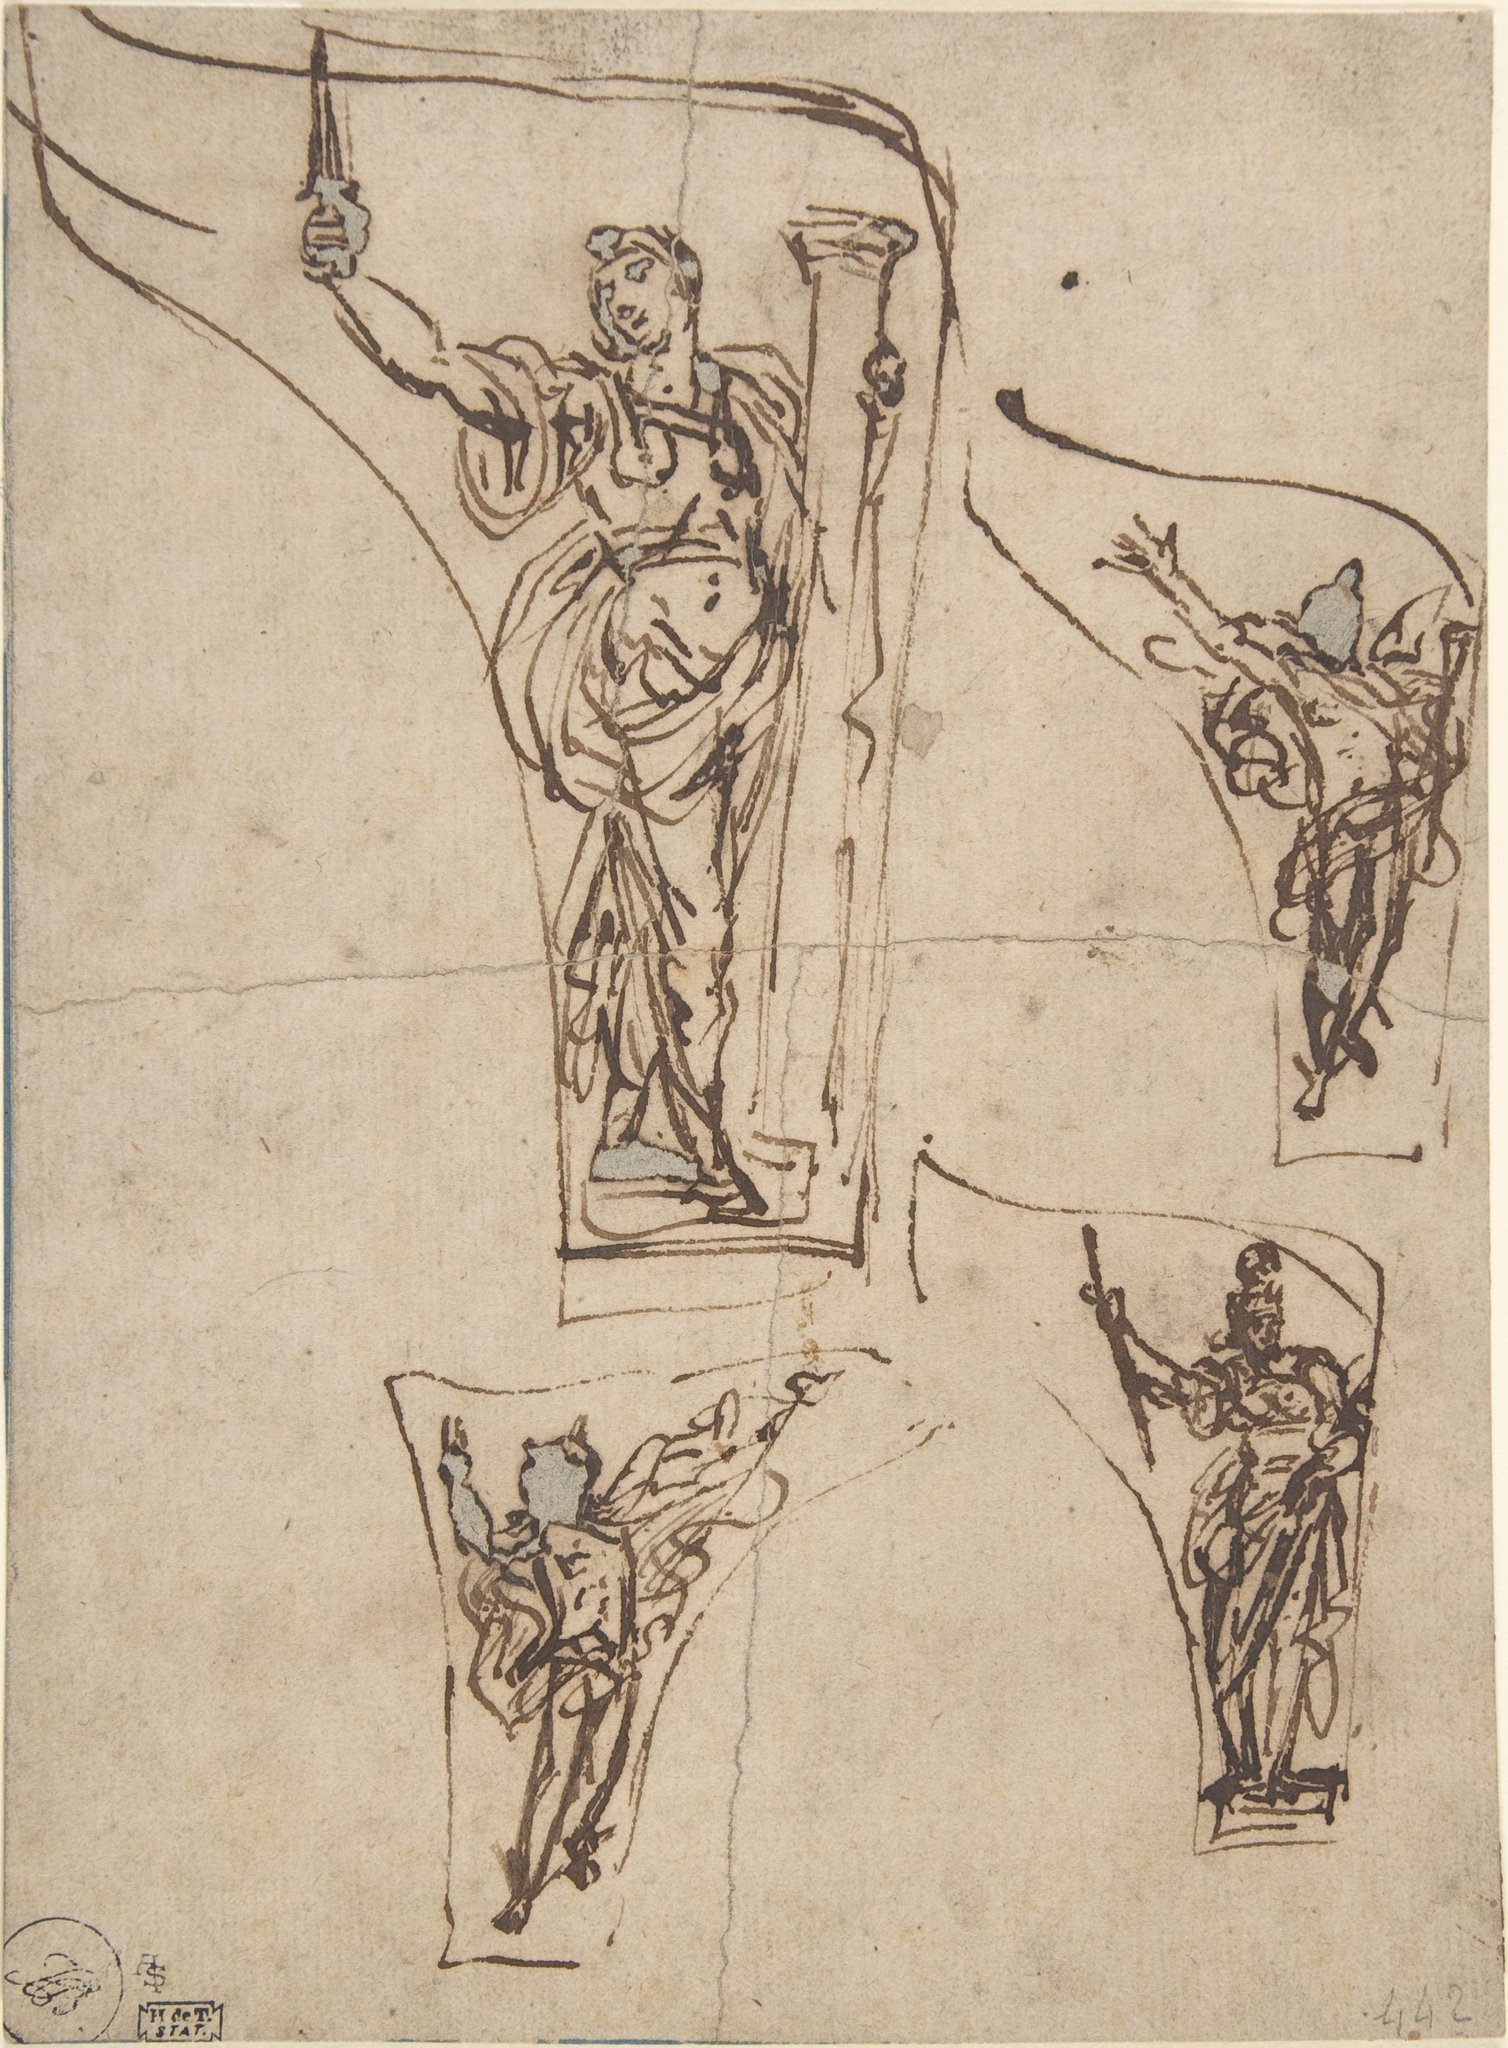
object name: drawing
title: Studies for a Decorative Object (Banner or Pendentive?) Representing Allegorical Figures, One of Which Appears to Be Fortitude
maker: anonymous, italian, 17th century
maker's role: artist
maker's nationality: italian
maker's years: 1600-1700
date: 1601-1700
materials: ink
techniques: pen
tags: human figures